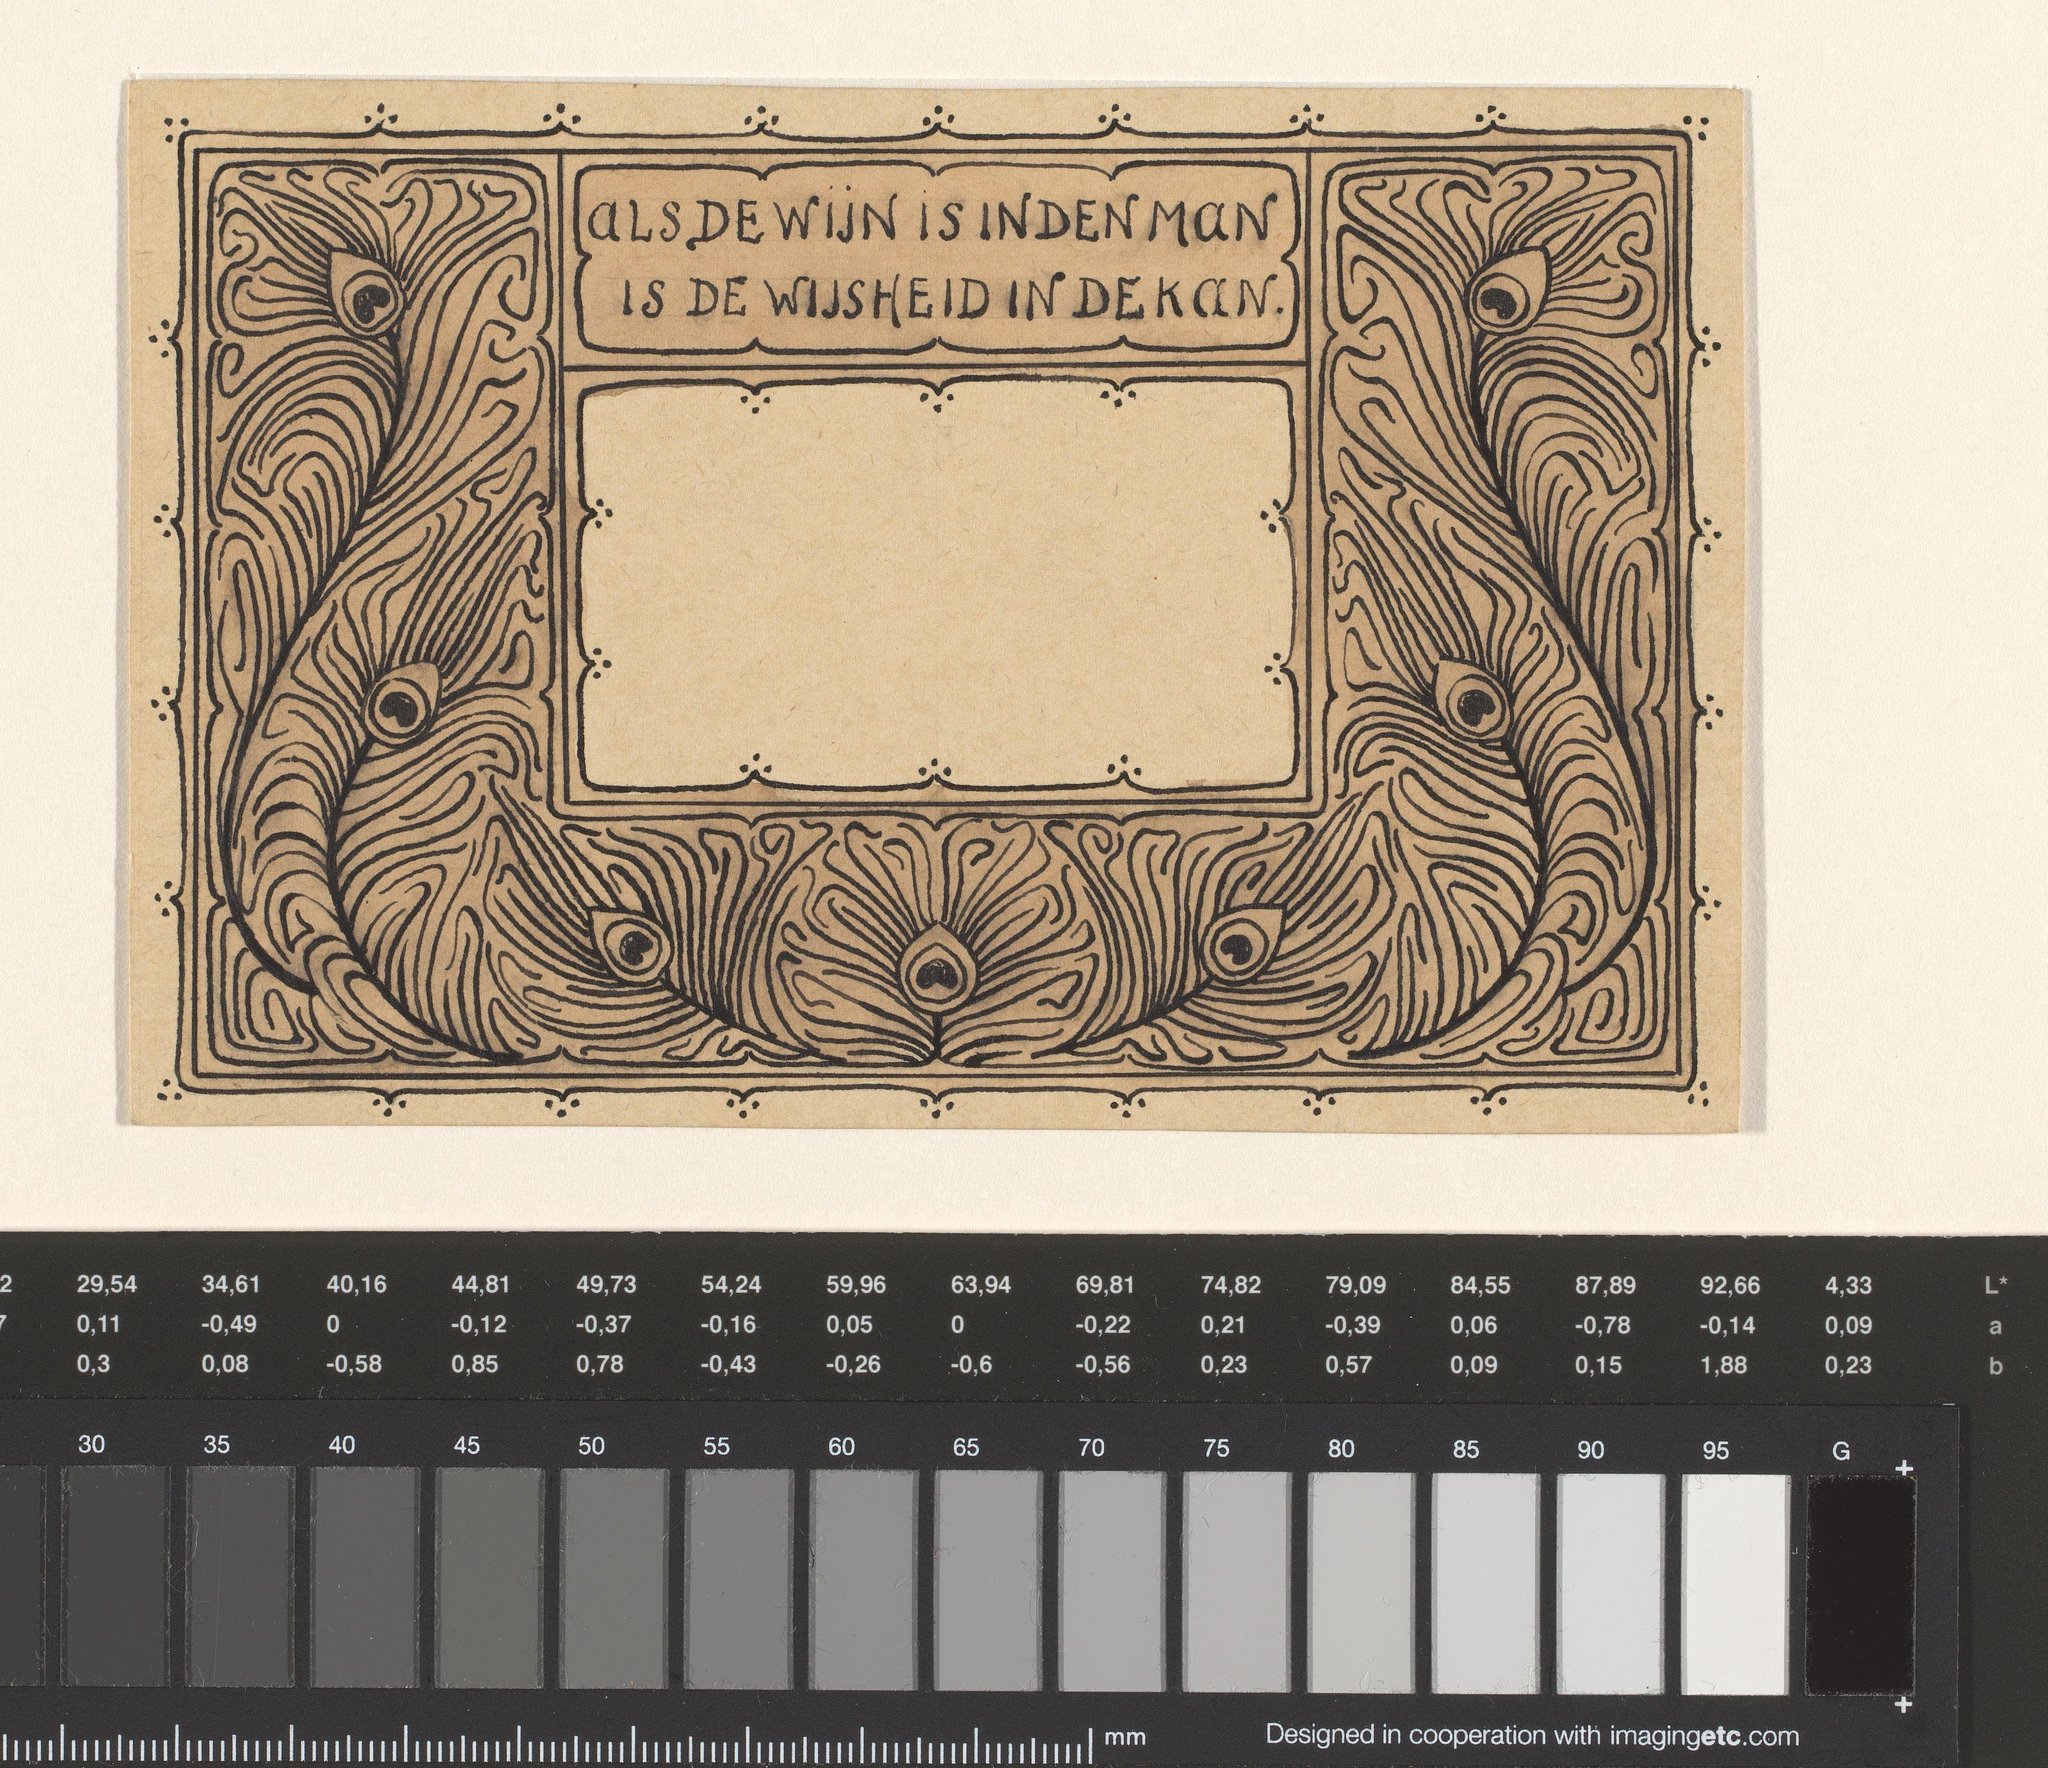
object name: drawing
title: Spreekwoord in ornamentale omlijsting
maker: julie de graag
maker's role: draughtsman, print maker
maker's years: 1877-1924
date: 1887-1924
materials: ink, paper, pencil, watercolor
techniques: brush, pen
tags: ornaments ~ art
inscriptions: number: ‘181’